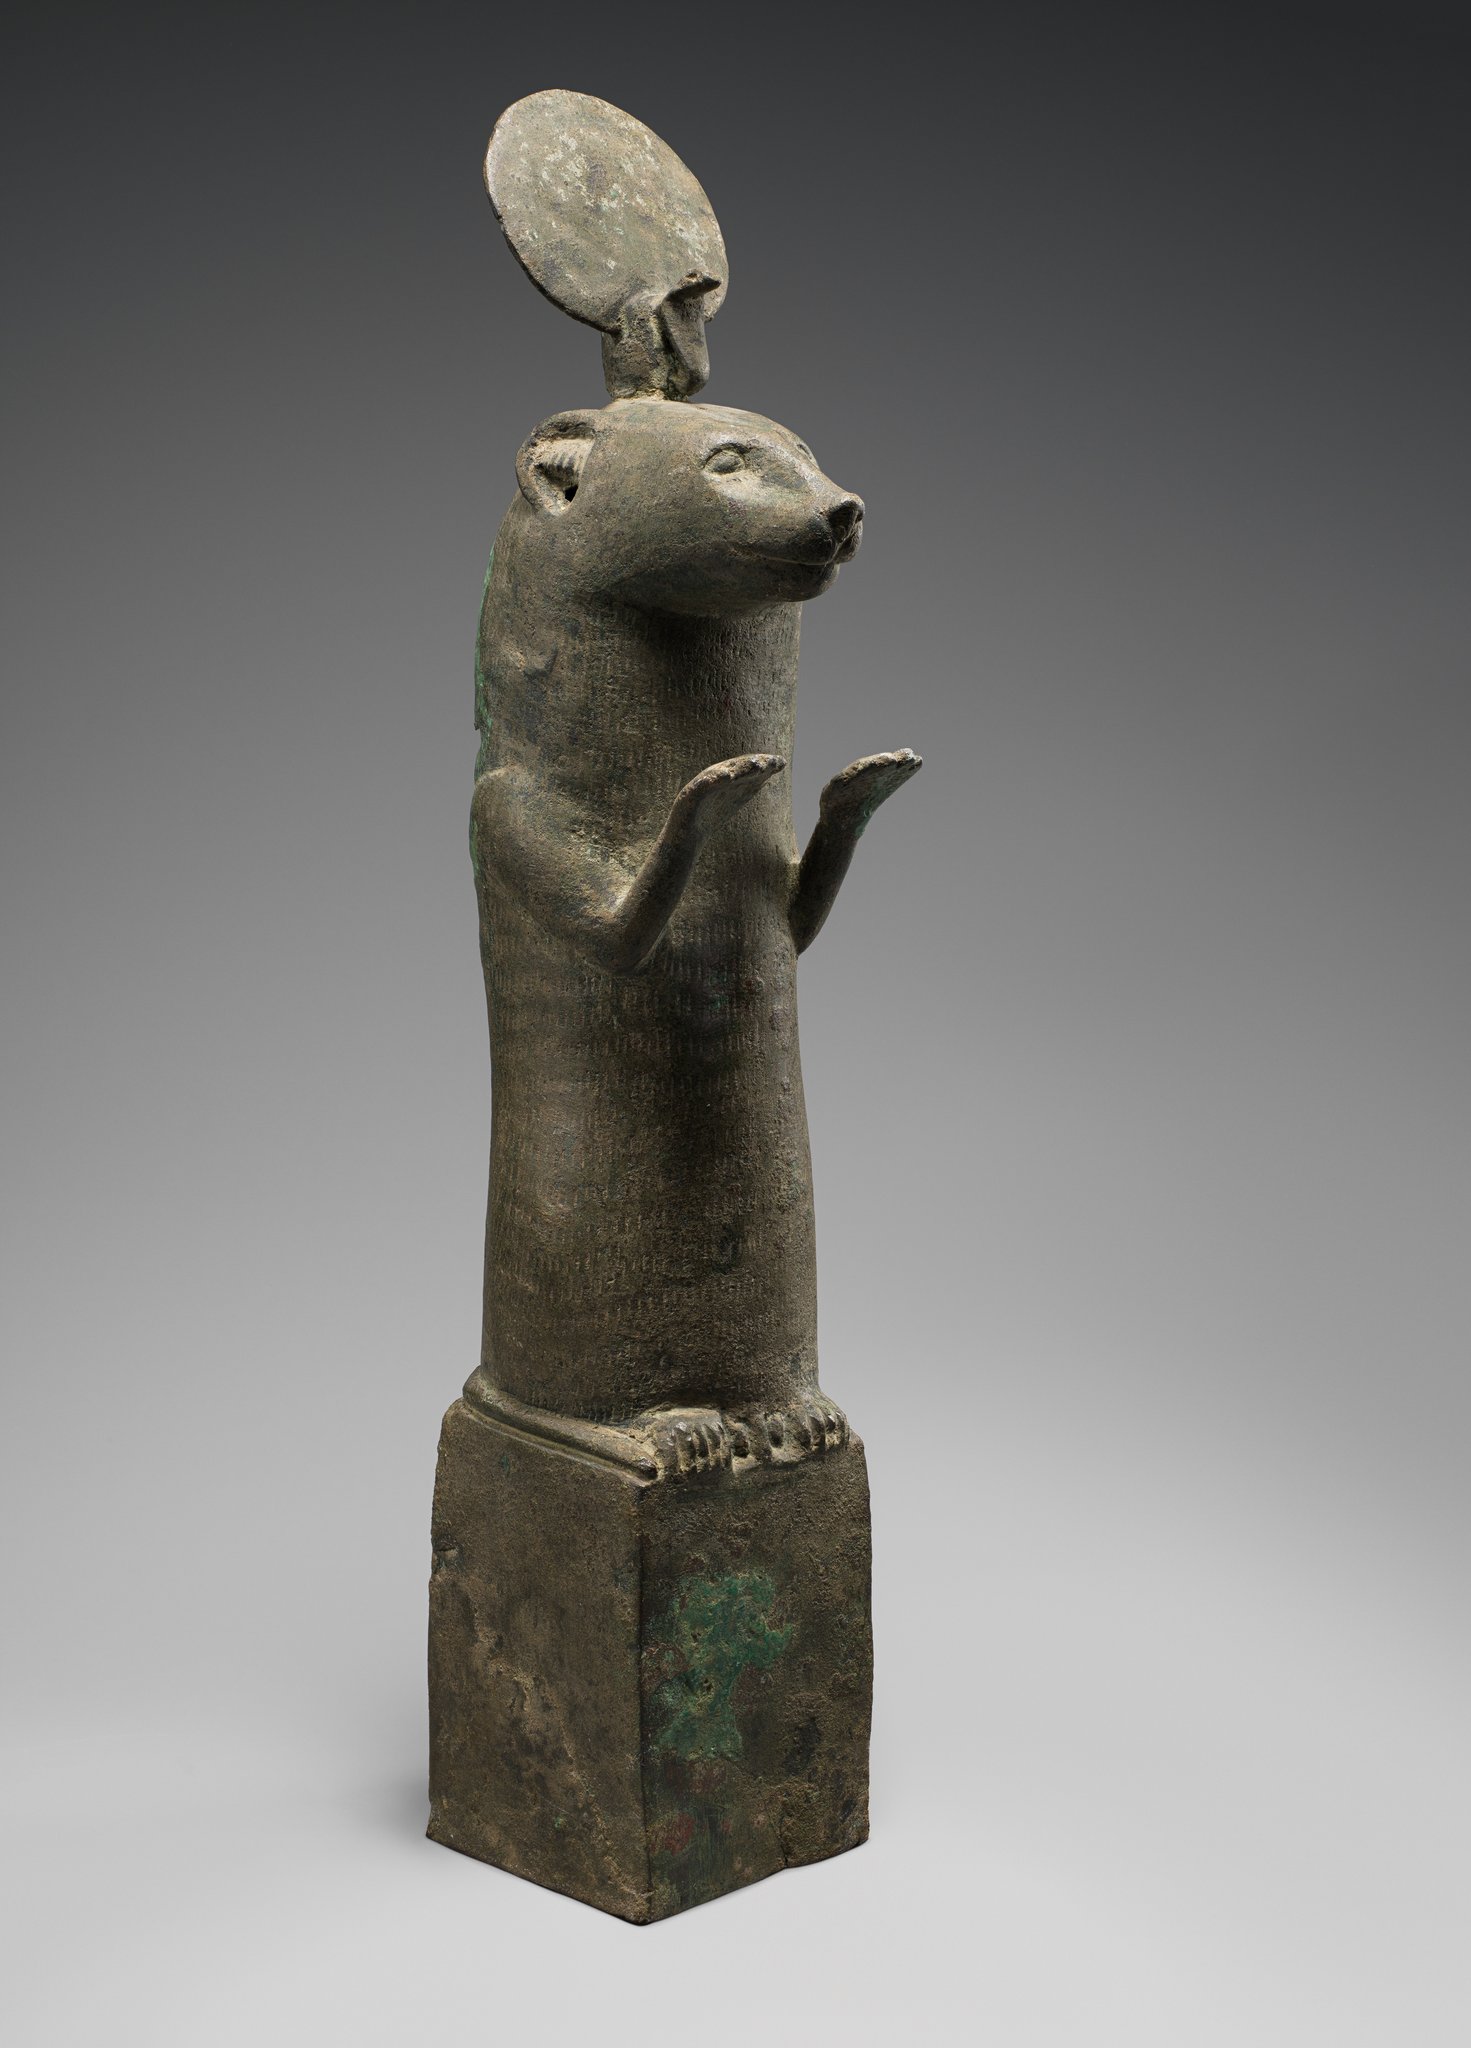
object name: statue, otter, mongoose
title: Statuette of an animal symbolizing Re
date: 664-630 BCE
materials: metal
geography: egypt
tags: animals